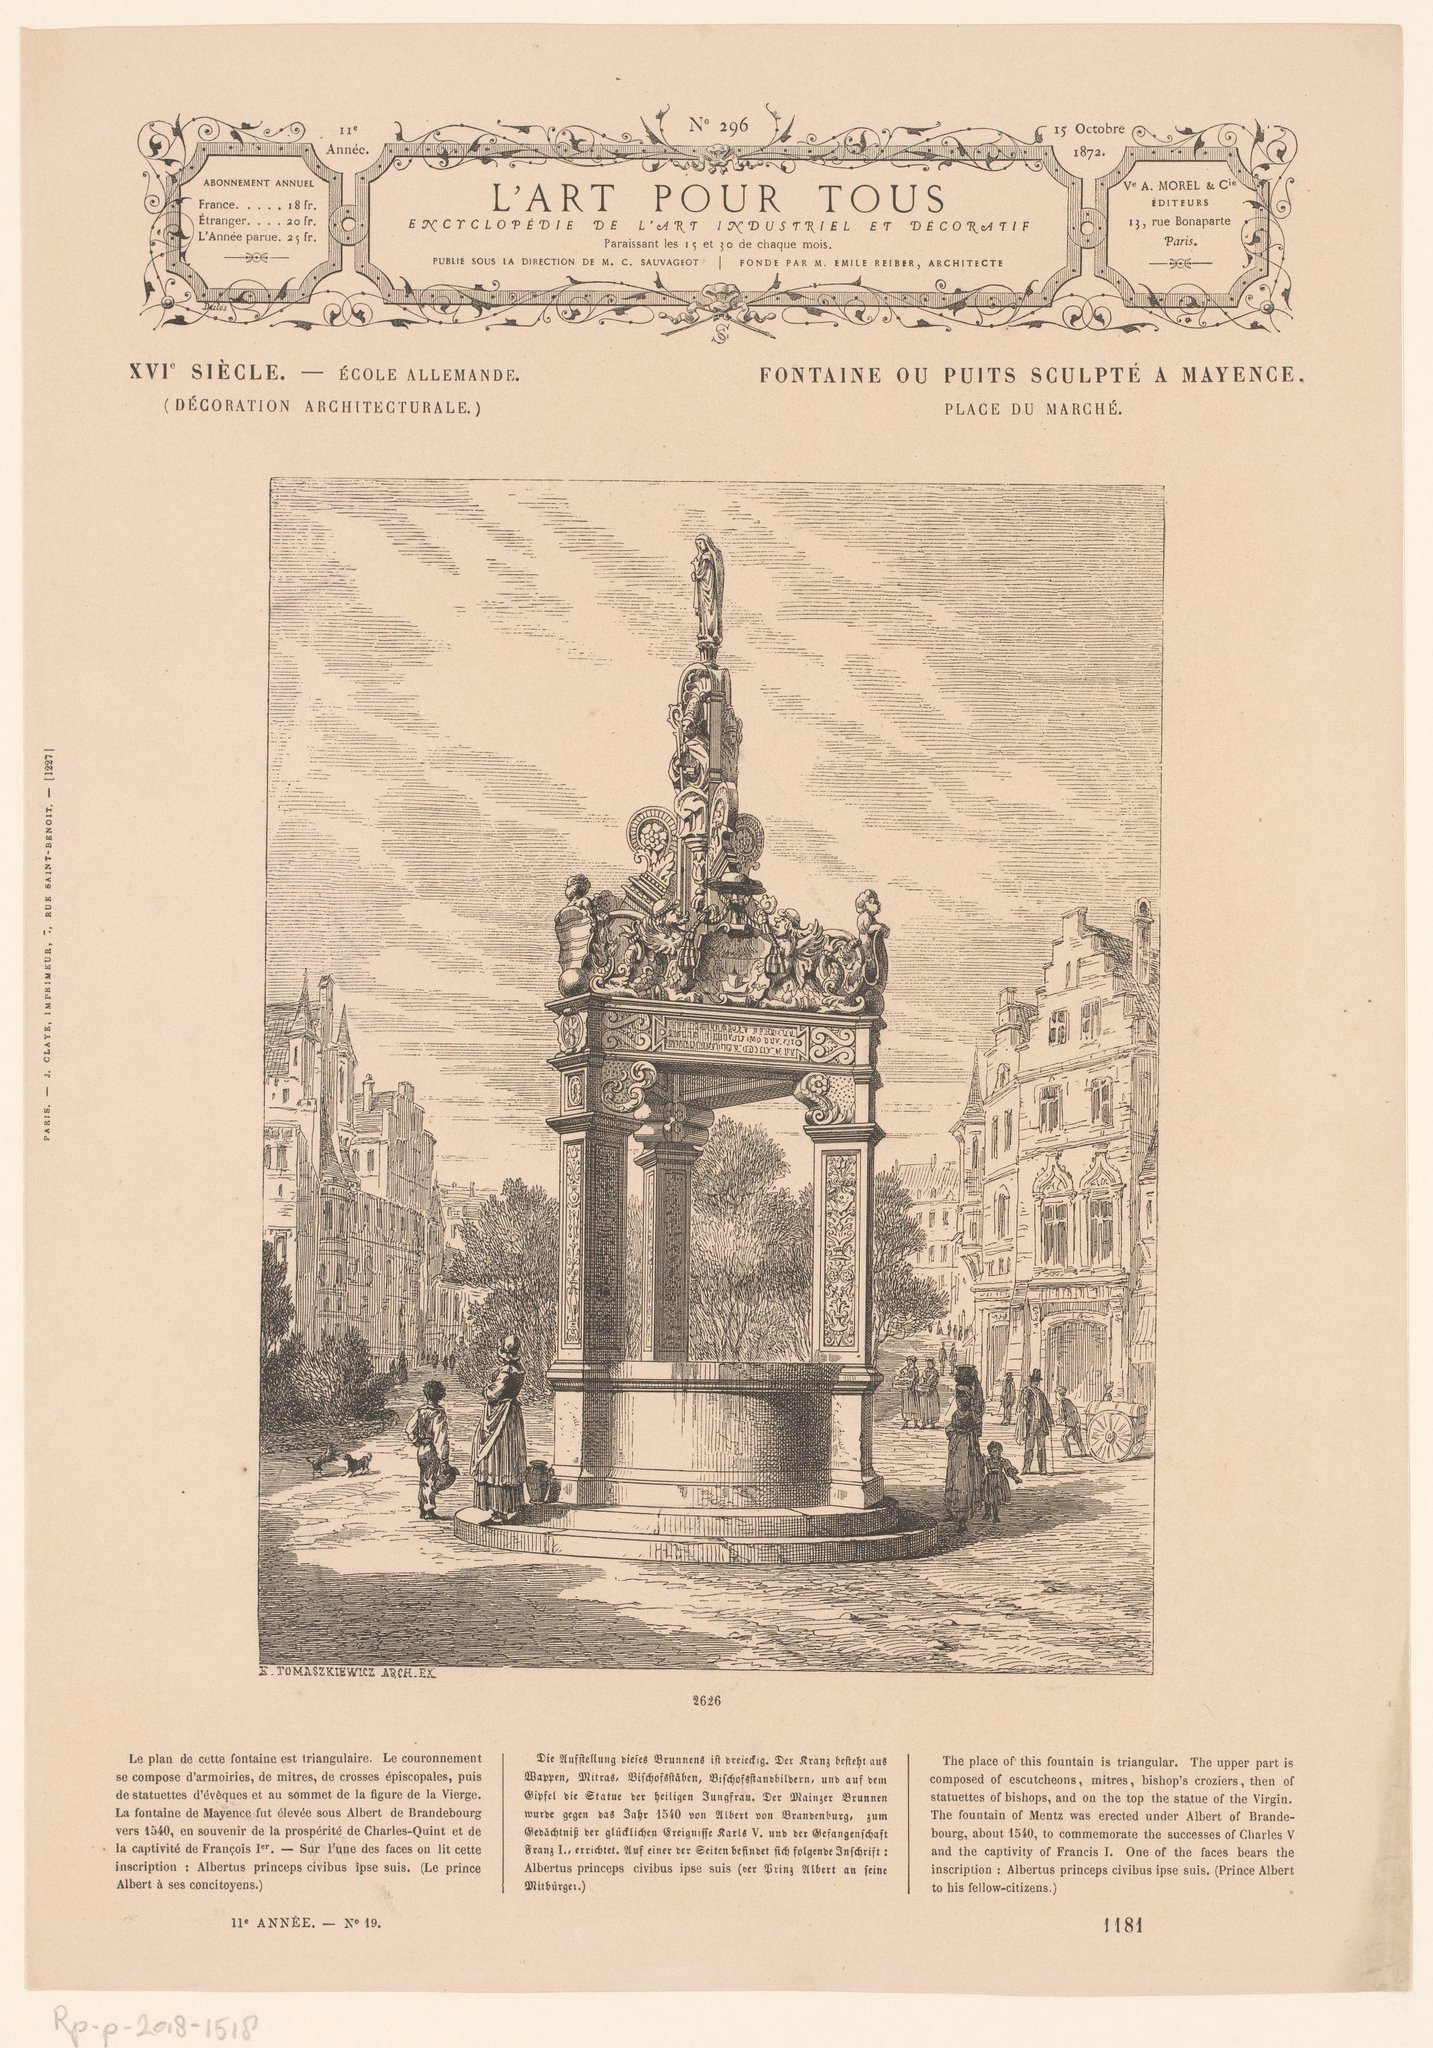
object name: print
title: Gezicht op Marktbrunnen, te Mainz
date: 1872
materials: paper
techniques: etching, letterpress printing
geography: paris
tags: well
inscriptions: collector's mark: Lugt 3937, collector's mark: Lugt 2228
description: Blad uit: L'Art pour tous; encyclopedie de l'art indrustriel et decoratief. Parijs: Weduwe A. Morel, 15 oktober 1827.